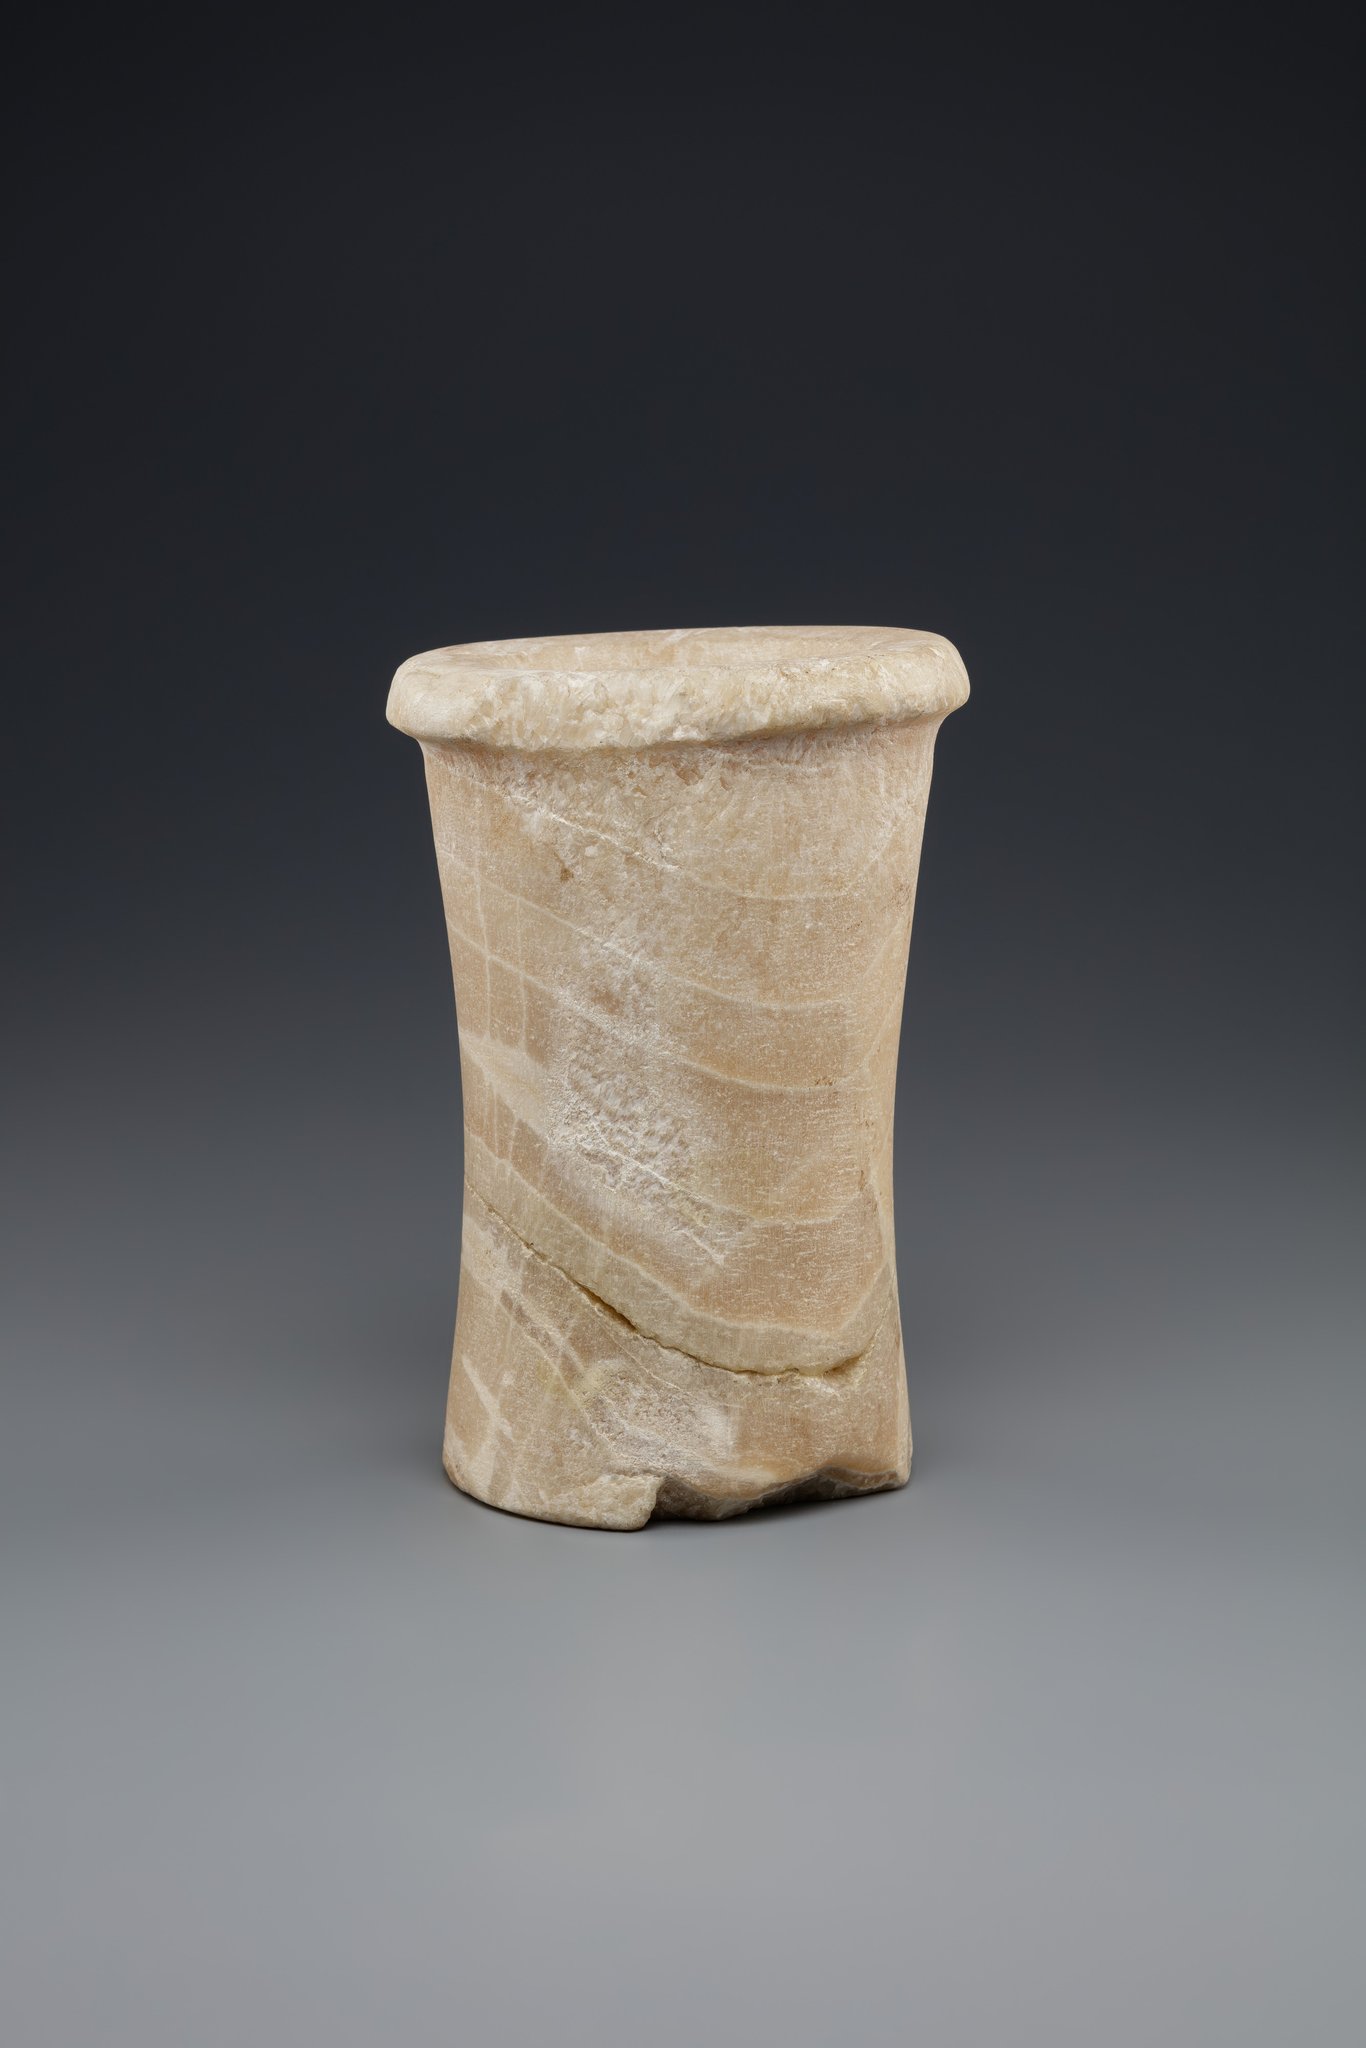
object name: jar, cylindrical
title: Cylinder jar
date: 3100-2649 BCE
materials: stone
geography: egypt